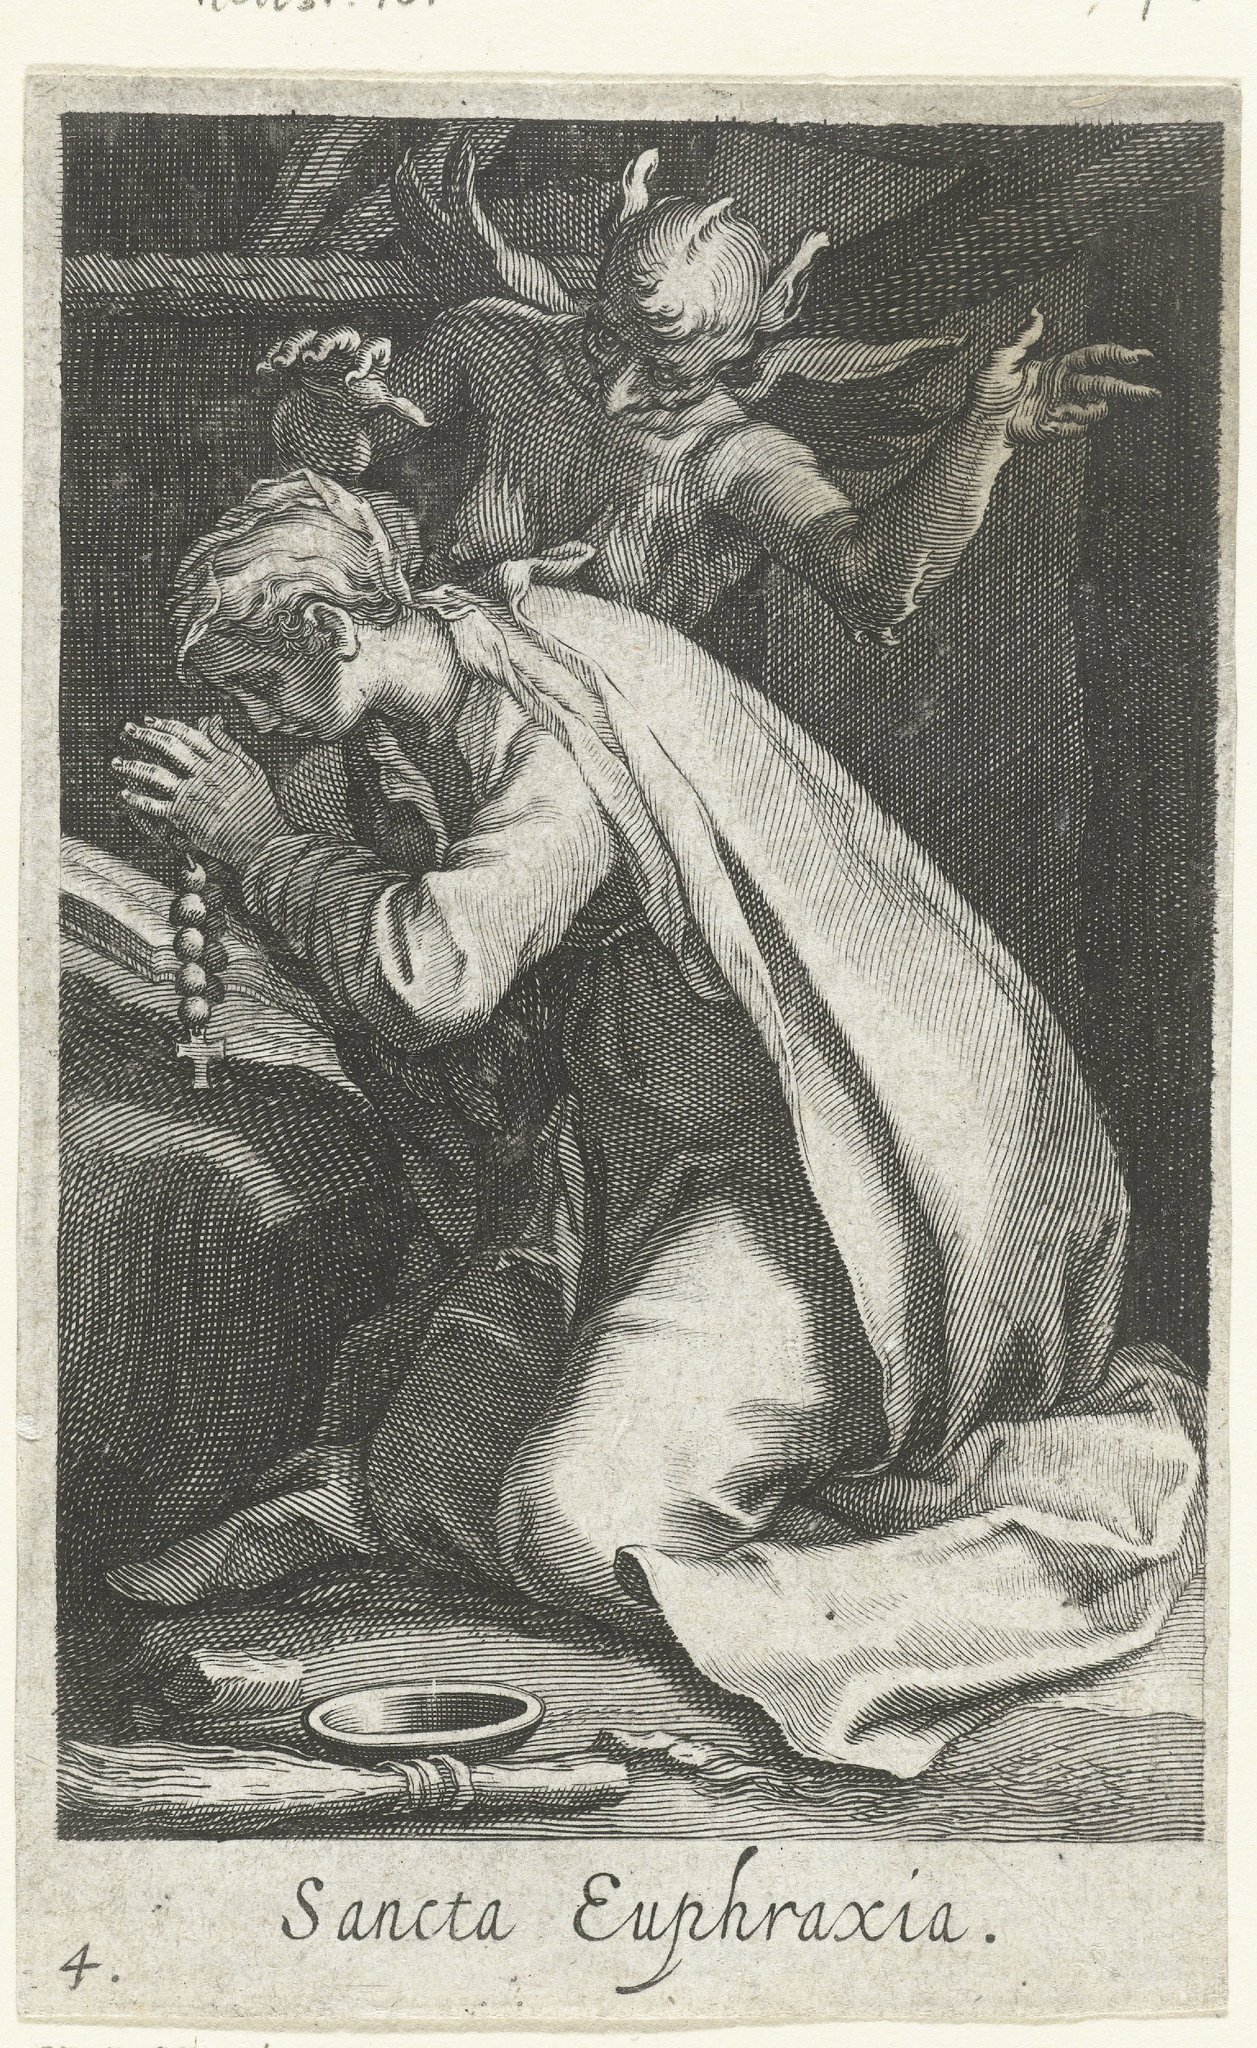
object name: print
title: Heilige Euphrasia van Constantinopel als kluizenares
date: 1590-1612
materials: paper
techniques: engraving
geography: antwerp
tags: devil(s) and demons, anchorite, hermit, female saints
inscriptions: collector's mark: Lugt 2228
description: Prent uit: Sacra Eremus Ascetriarum, Hendrik Aertssen, Antwerpen 1619. Prent uit de serie van vijfentwintig kluizenaressen in deze uitgave. In 1612 verscheen de ongebonden editie maar op basis van de gewijzigde opschriften en samenstelling van de serie kluizenaars wordt aangenomen dat de prenten van de uitgave 1619 ook in 1612 of iets daarvoor gedrukt werden. De serie kluizenaressen bleef vrijwel ongewijzigd in de ongebonden uitgave van 1612, dit compliceert de datering van de losse bladen in de collectie van het RMA, zie Roethlisberger 1993, p. 171-175. Door de aanwezigheid van Franse tekst op het verso kunnen we vaststellen dat dit blad afkomstig is uit de Antwerpse uitgave van 1619.